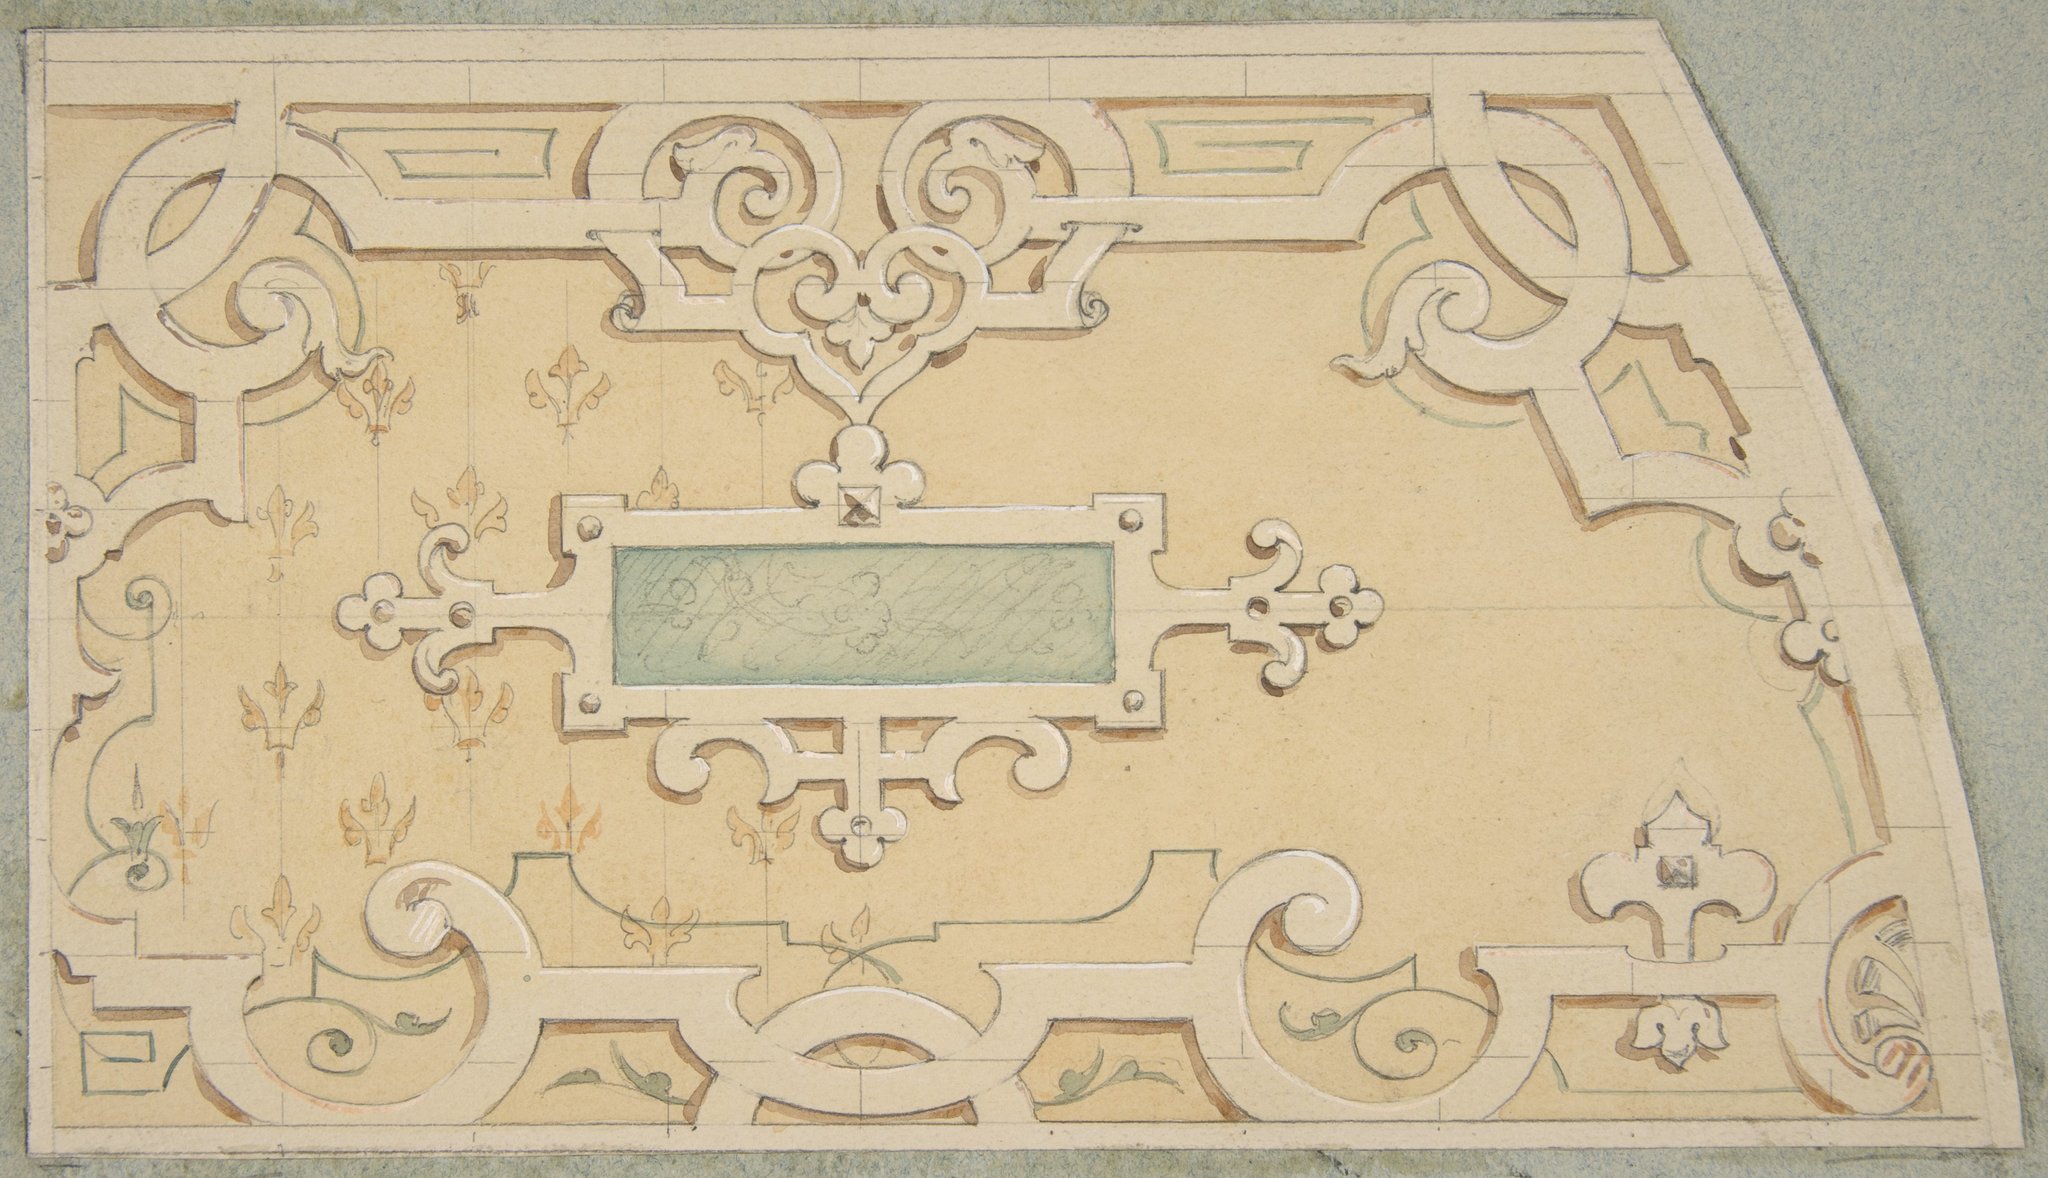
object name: drawing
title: Design for the decoration of the stairway in the Chateau d'Ognon of M. de Machy (Oise, France)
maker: jules-edmond-charles lachaise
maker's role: artist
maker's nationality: french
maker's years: 1897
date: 1851-1900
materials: graphite, watercolor, paper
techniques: heightening, inlay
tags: architecture